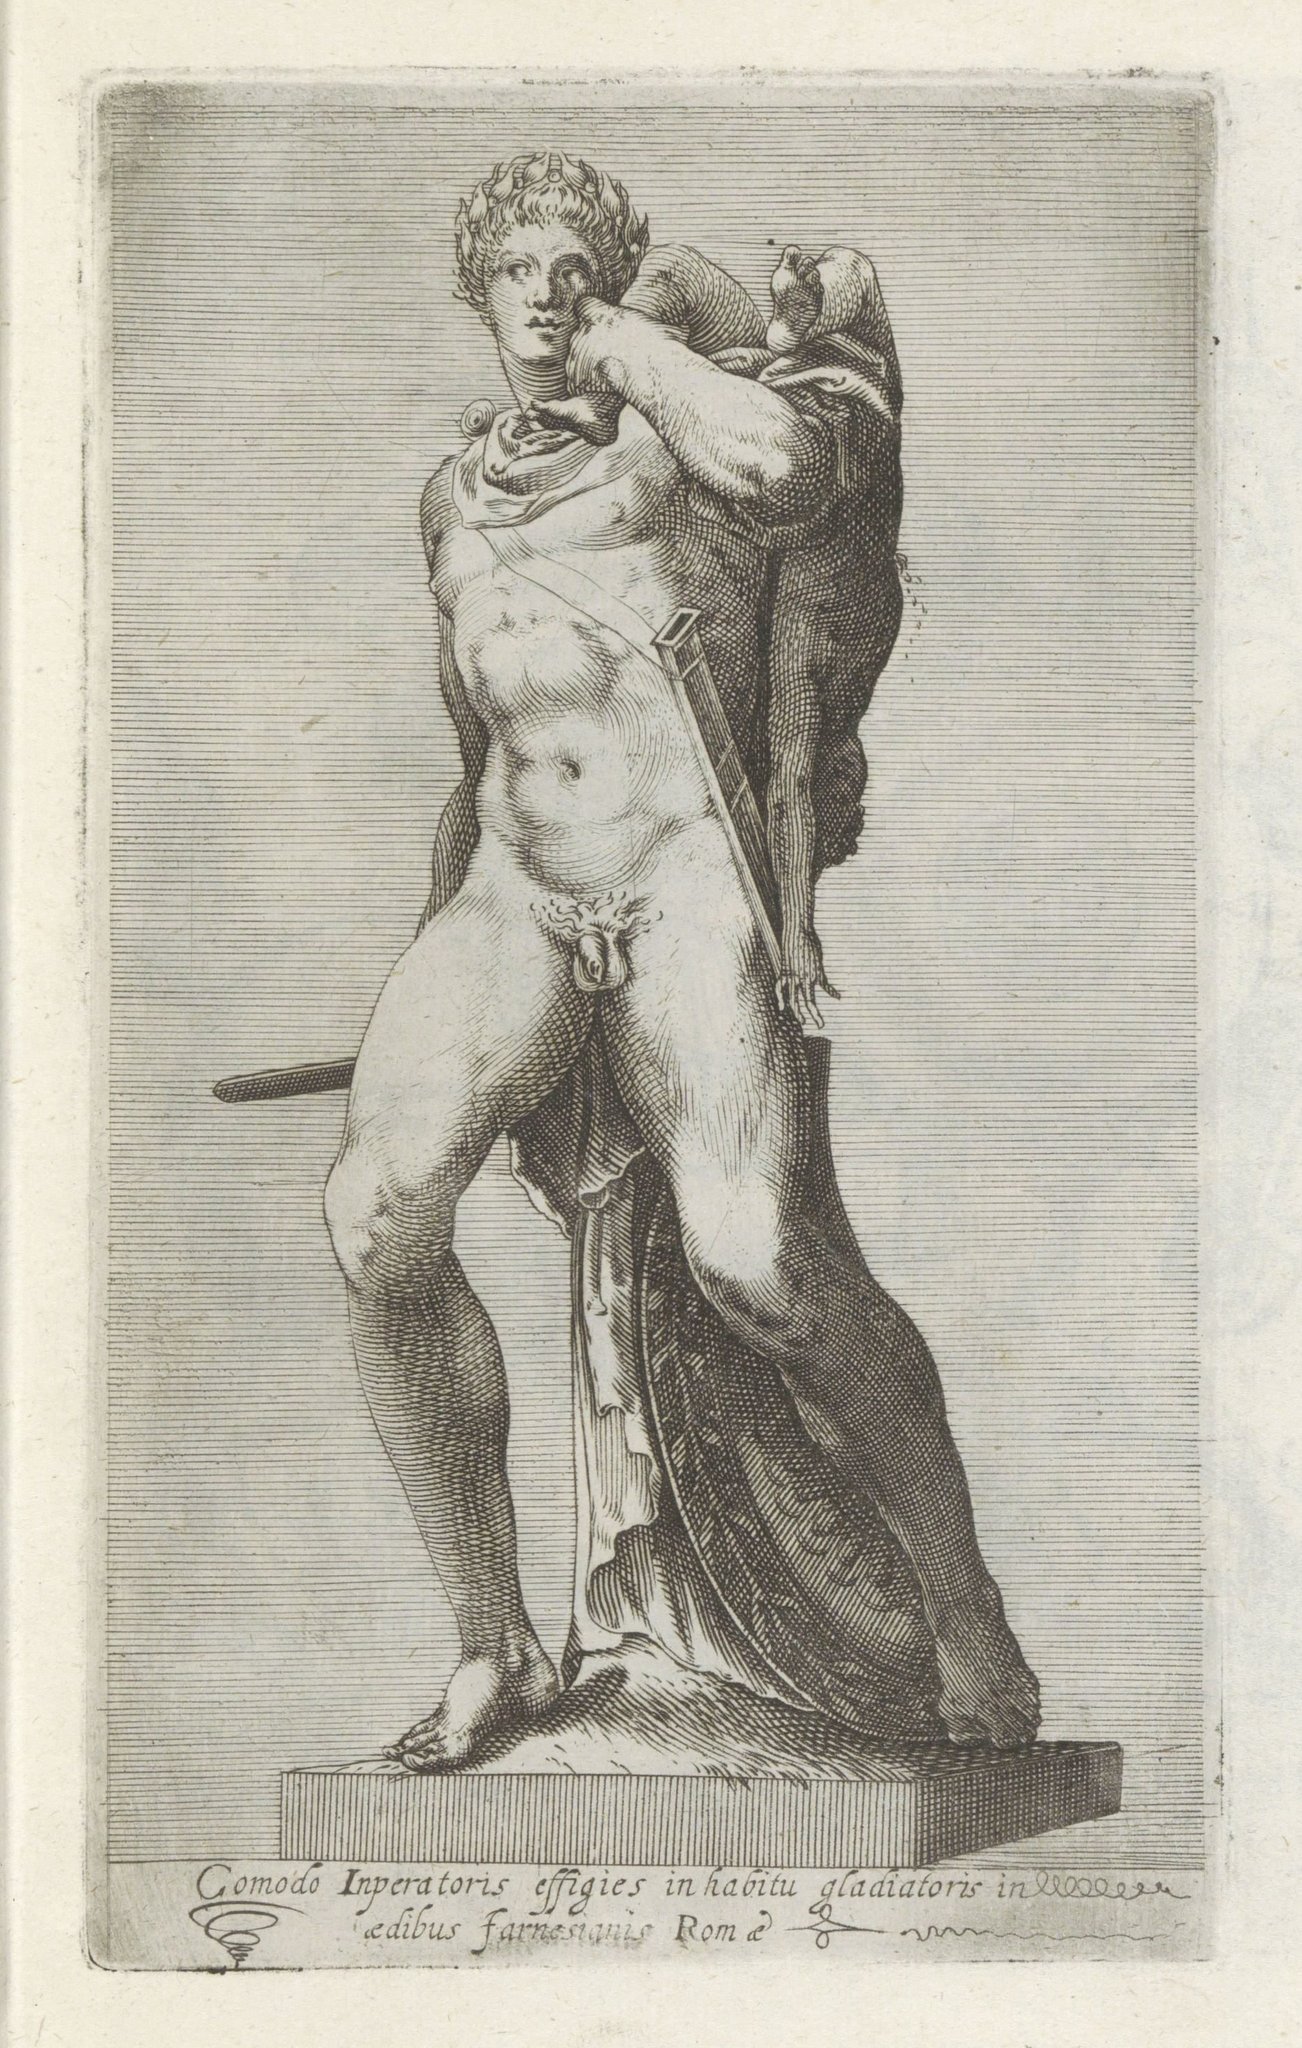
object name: print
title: Comodo inperatoris effigies in habitu glariatoris (...)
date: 1584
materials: paper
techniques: engraving, intaglio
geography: italy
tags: piece of sculpture, reproduction of a piece of sculpture, ruler, sovereign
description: Deze prent maakt deel uit van een set van 79 prenten (+ titelprent) met voorstellingen van antieke sculpturen in Rome.